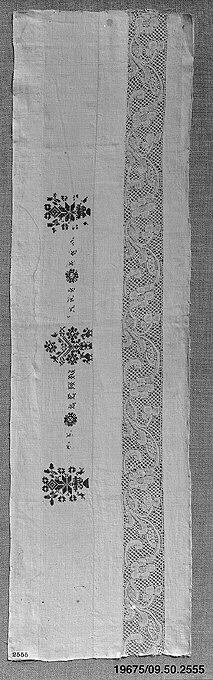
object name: fragment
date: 1801-1900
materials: linen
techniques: lace